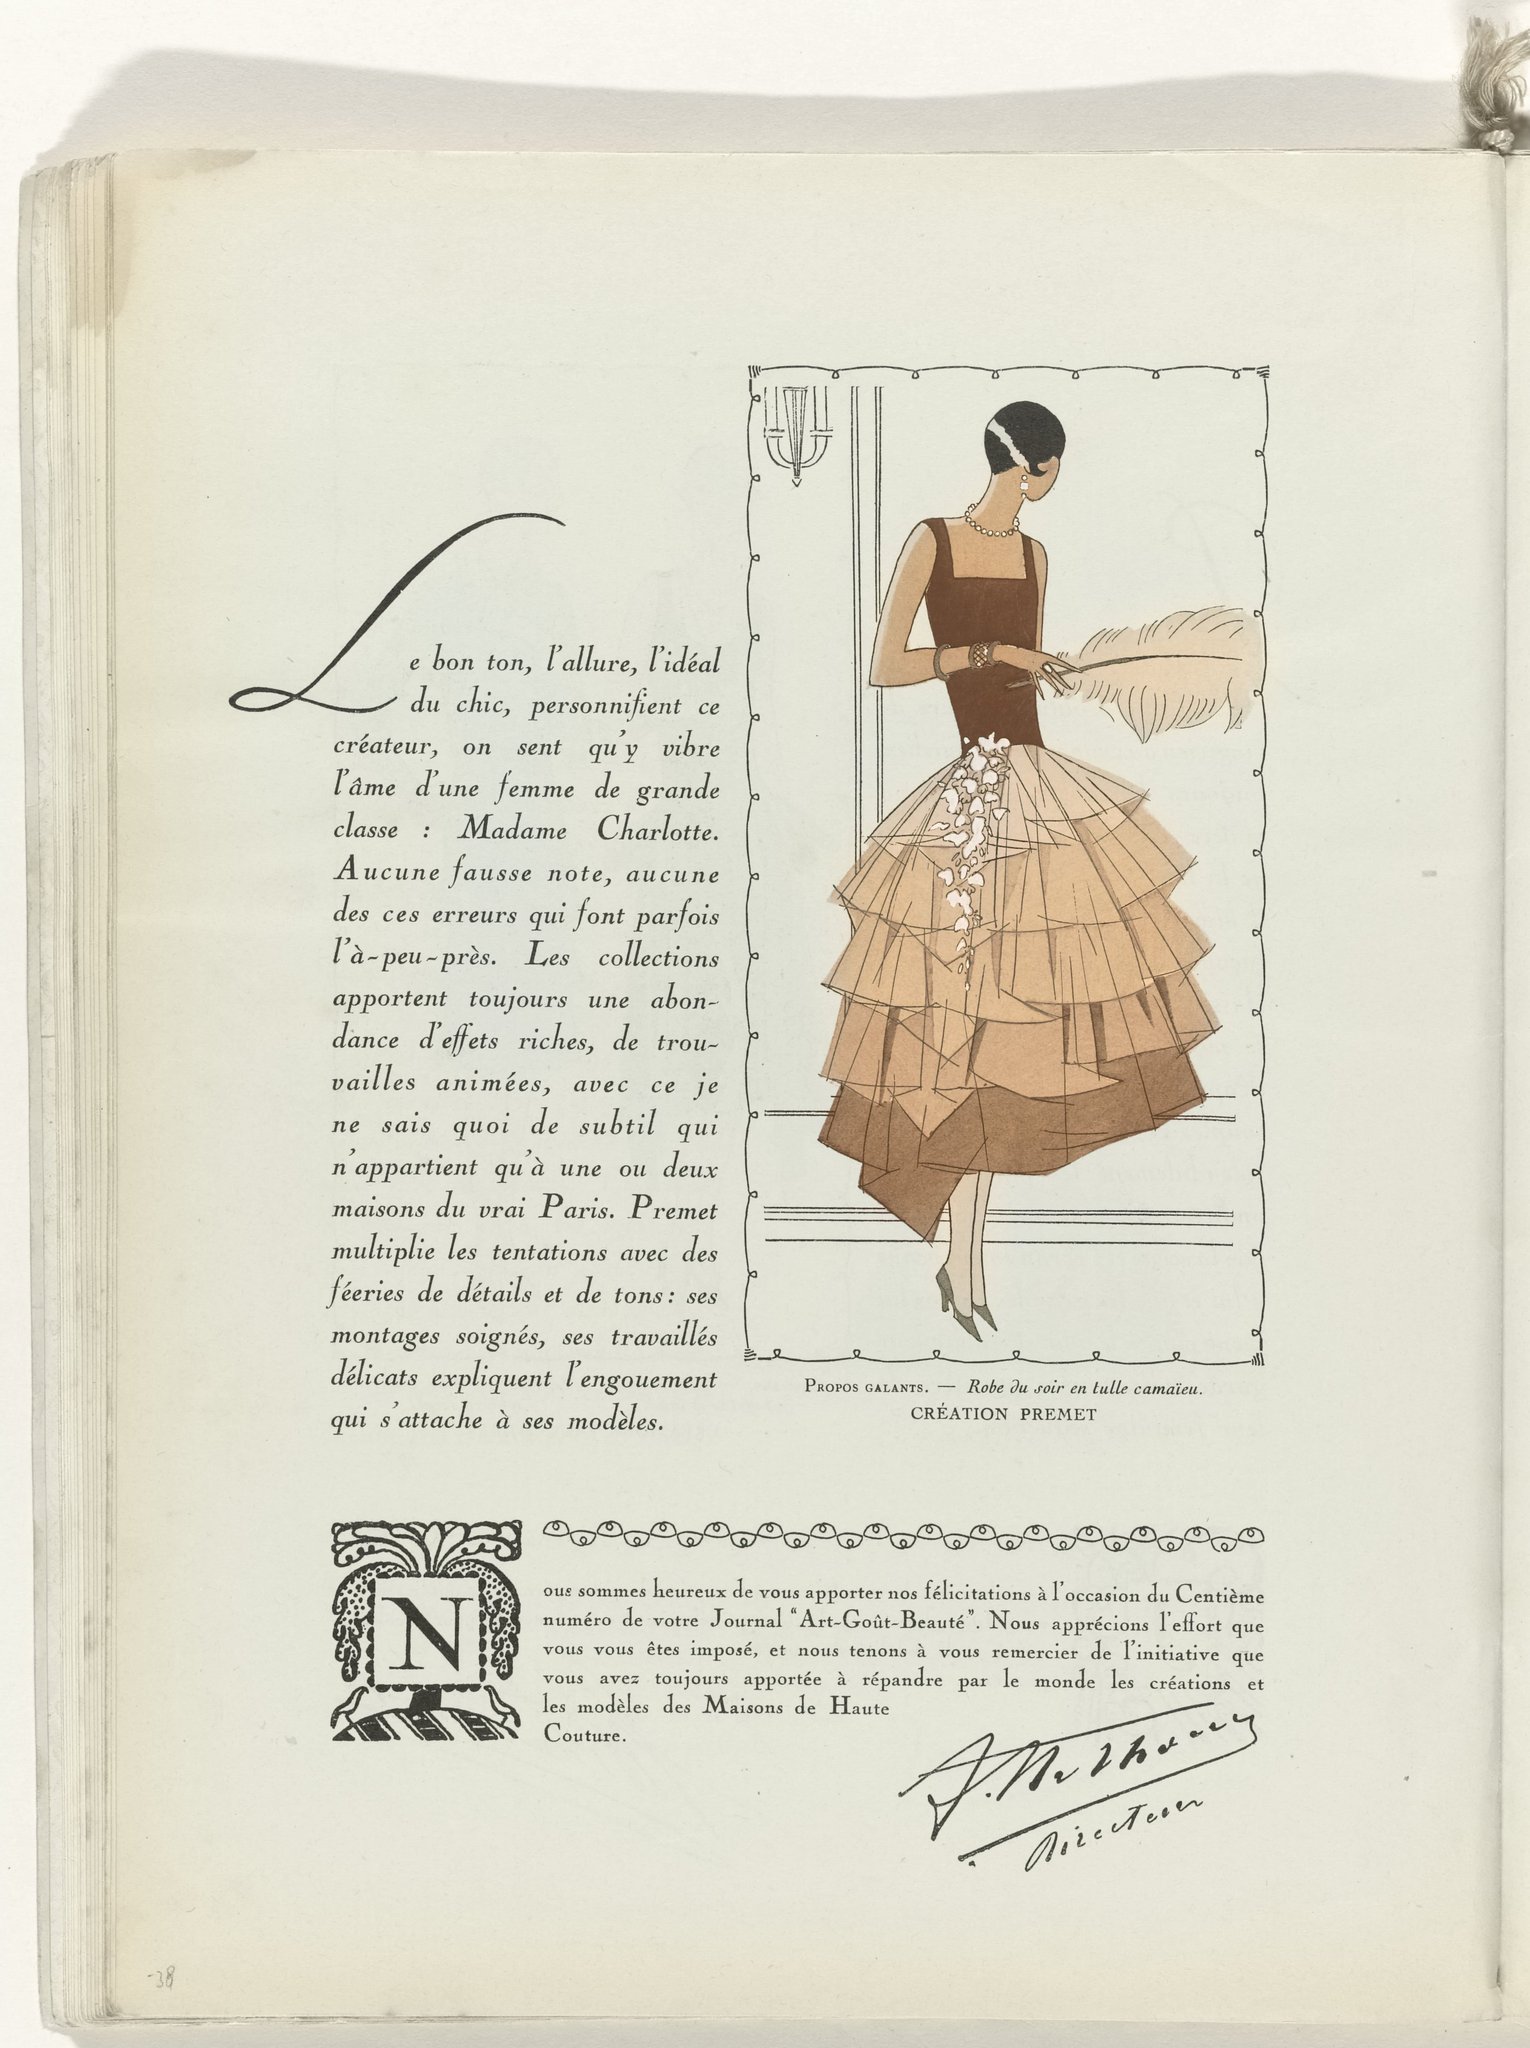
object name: magazine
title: Art - Goût - Beauté, Feuillets de l' élégance féminine, Noël 1928, No. 100, 9e Année, p. 38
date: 1928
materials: paper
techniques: brush, hand coloring, lithograph, pochoir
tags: corsage (+ women's clothes), flowers, dress, gown: evening dress (+ women's clothes), fashion plates, fan (+ feathers used for clothes), necklace (+ women's clothes)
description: Tekst met een afbeelding van een vrouw in een avondjurk van monochrome bruine tule, van Premet. Bloemcorsage op de rok. Veren waaier in de hand. Pagina uit het modetijdschrift Art-Goût-Beauté (1920-1933).